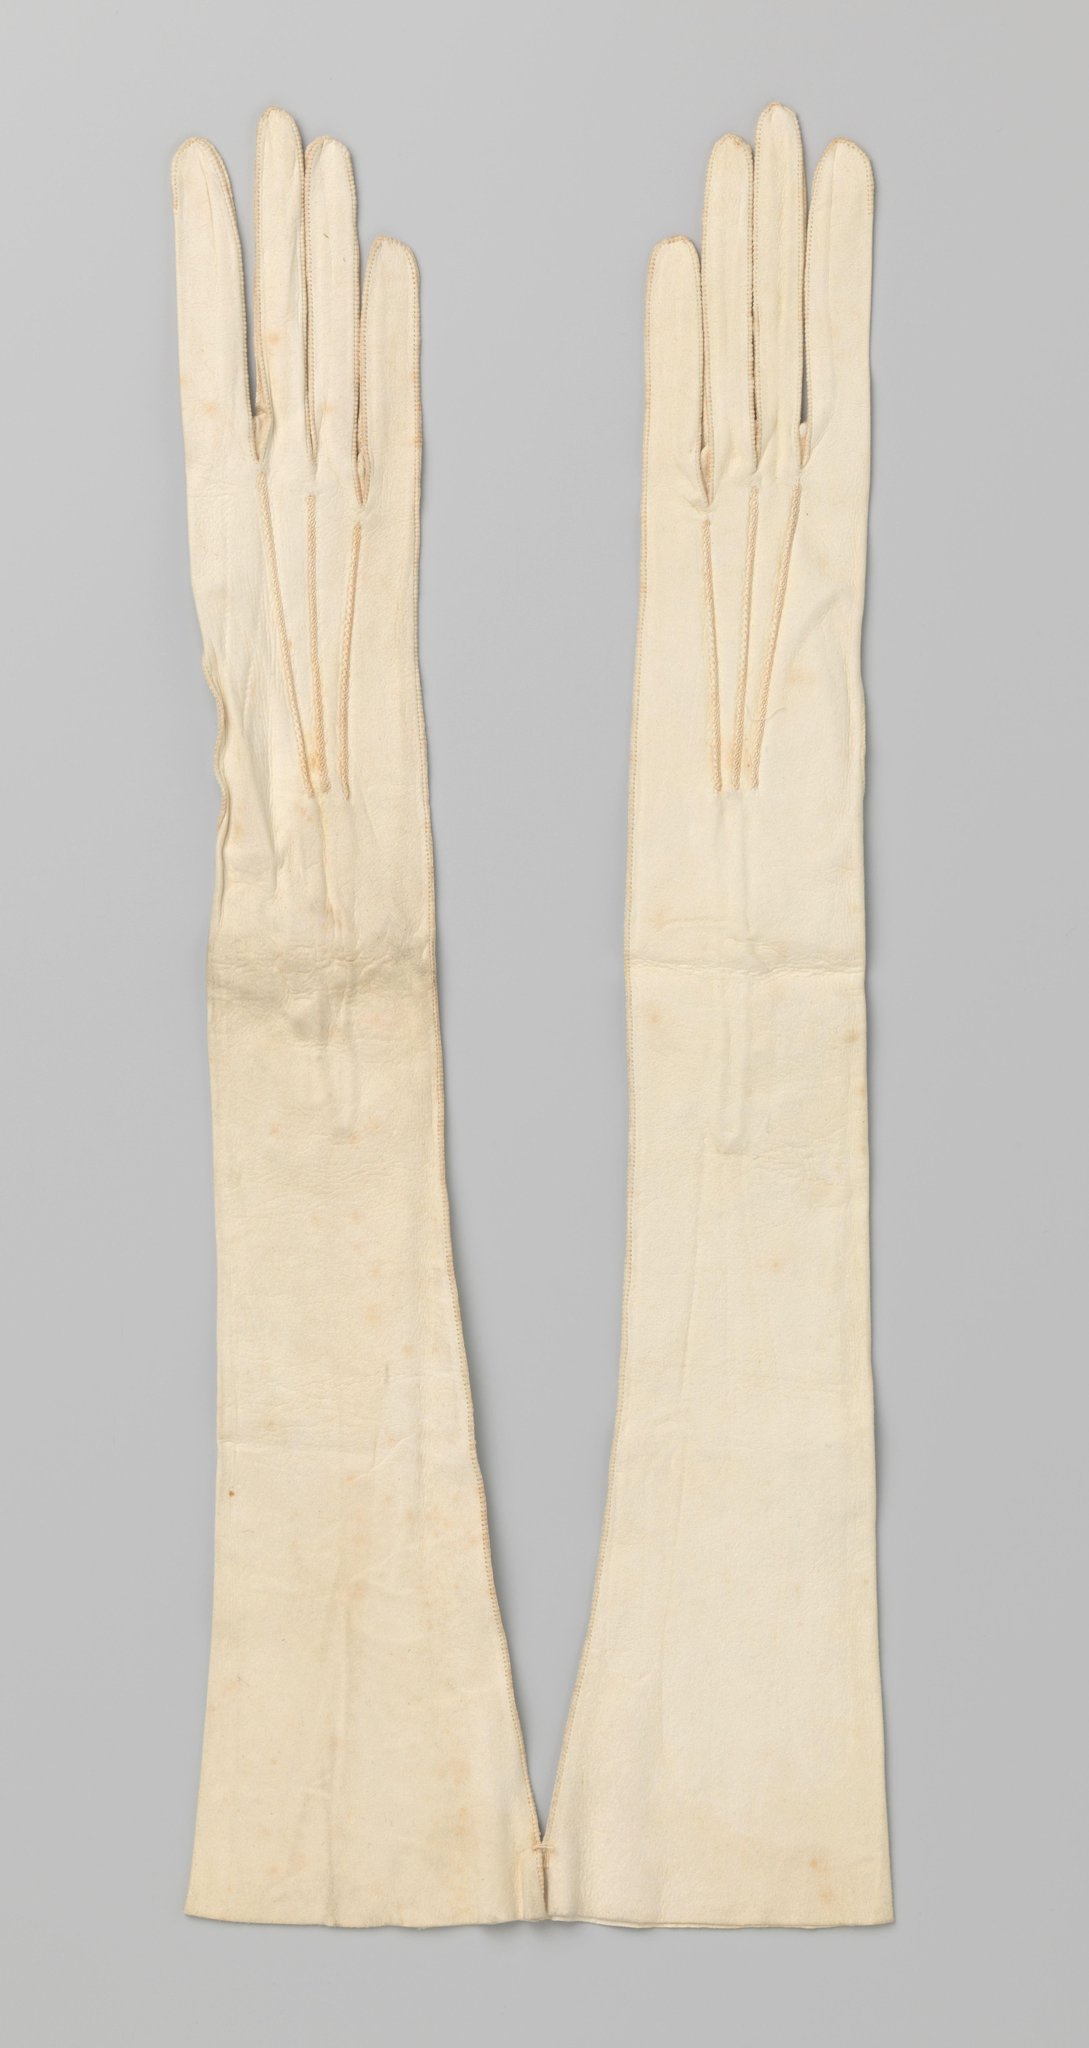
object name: womenswear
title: Handschoen van beige zeemleer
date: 1900-1935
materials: leather, mother of pearl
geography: netherlands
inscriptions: stamp: ‘letter en cijfers’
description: Paar lange visitehandschoenen van wit zeemleer. Model: Ellebooglang, met gezoomd polssplitje met twee minustule parelmoeren knoopjes. Alle naden met festonsteken-waarschijnlijk op de machine. Versiering: Op de handrug drie uitstralende pees-koordjes. Merken: Links: Odetti/Genova/Italia/4028. Rechts: F22/4028. Toestand: Winkelnieuw, nog met het draadje bovenaan verbonden. Opm.: Dat het paar nieuw is, bewijst niet dat het niet gebruikt is, want een dame, die uitging op bezoek, hield de handschoenen dikwijls dubbelgevouwen in de hand. Deze lengte wijst op galakleding. Bijvoorbeeld bij een "raout", d.i. een receptie bij de koningen op het Paleis op de Dam. Daar kwamen alleen genodigden uit de Amsterdamse society. De dames moesten dan een japon met sleep dragen.